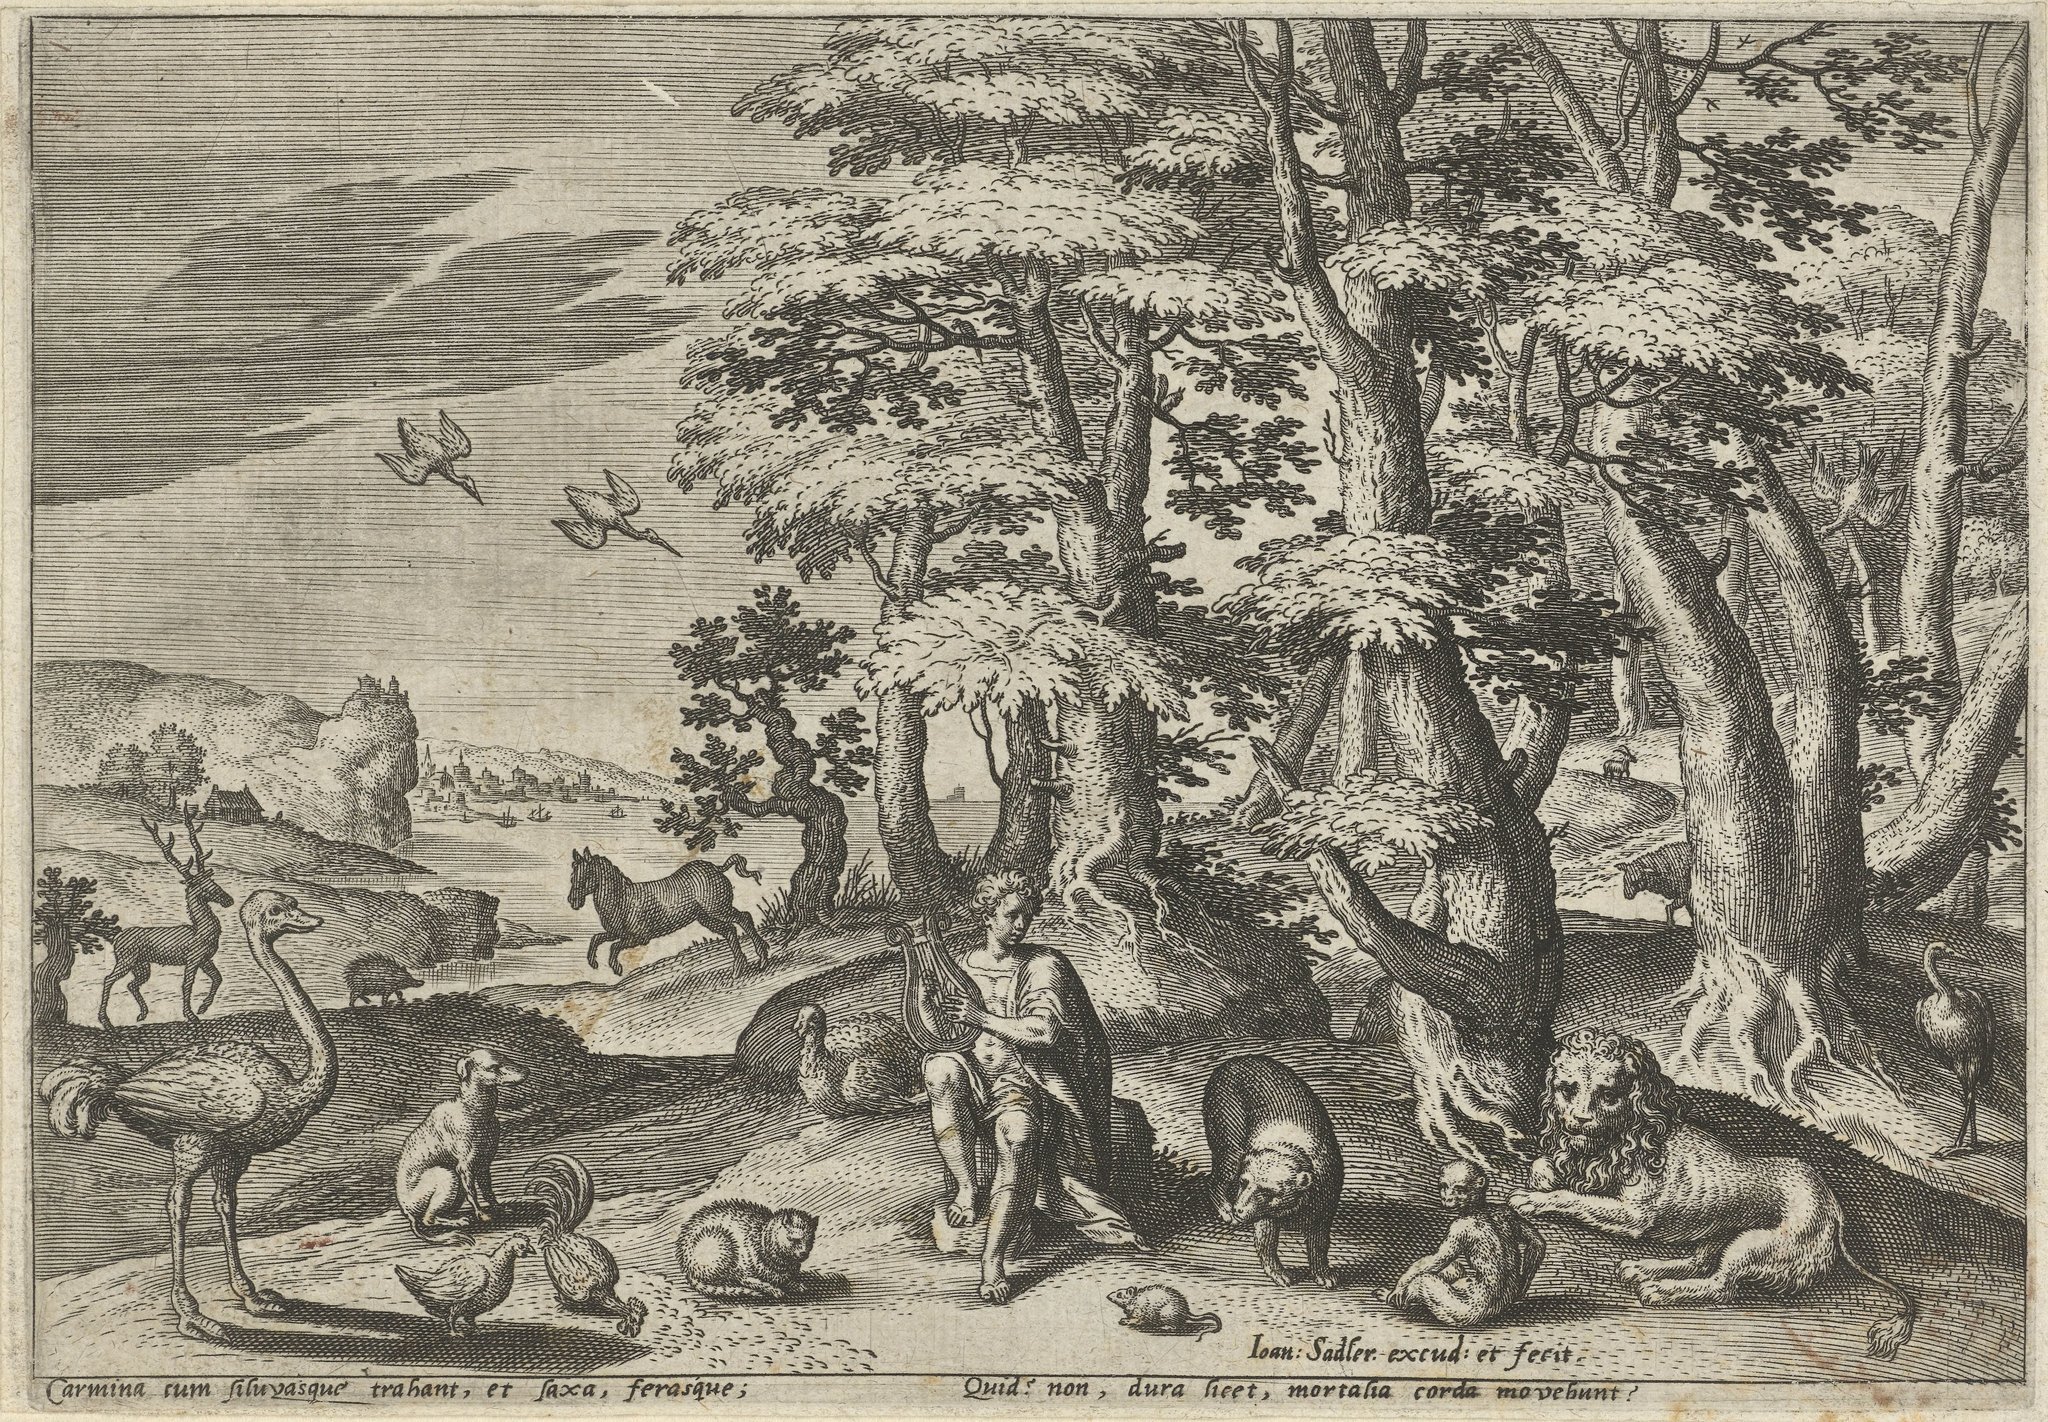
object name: print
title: Landschappen met mythologische scènes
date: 1560-1600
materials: paper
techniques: engraving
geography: antwerp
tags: landscapes, orpheus playing the lyre: trees and rocks move, beasts and birds are enchanted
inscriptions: collector's mark: Lugt 240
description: Landschap met dieren. Orpheus zit onder de bomen, omringd door dieren. Hij bespeelt de lier. De laatste prent van een zesdelige serie van landschappen met mythologische scènes.